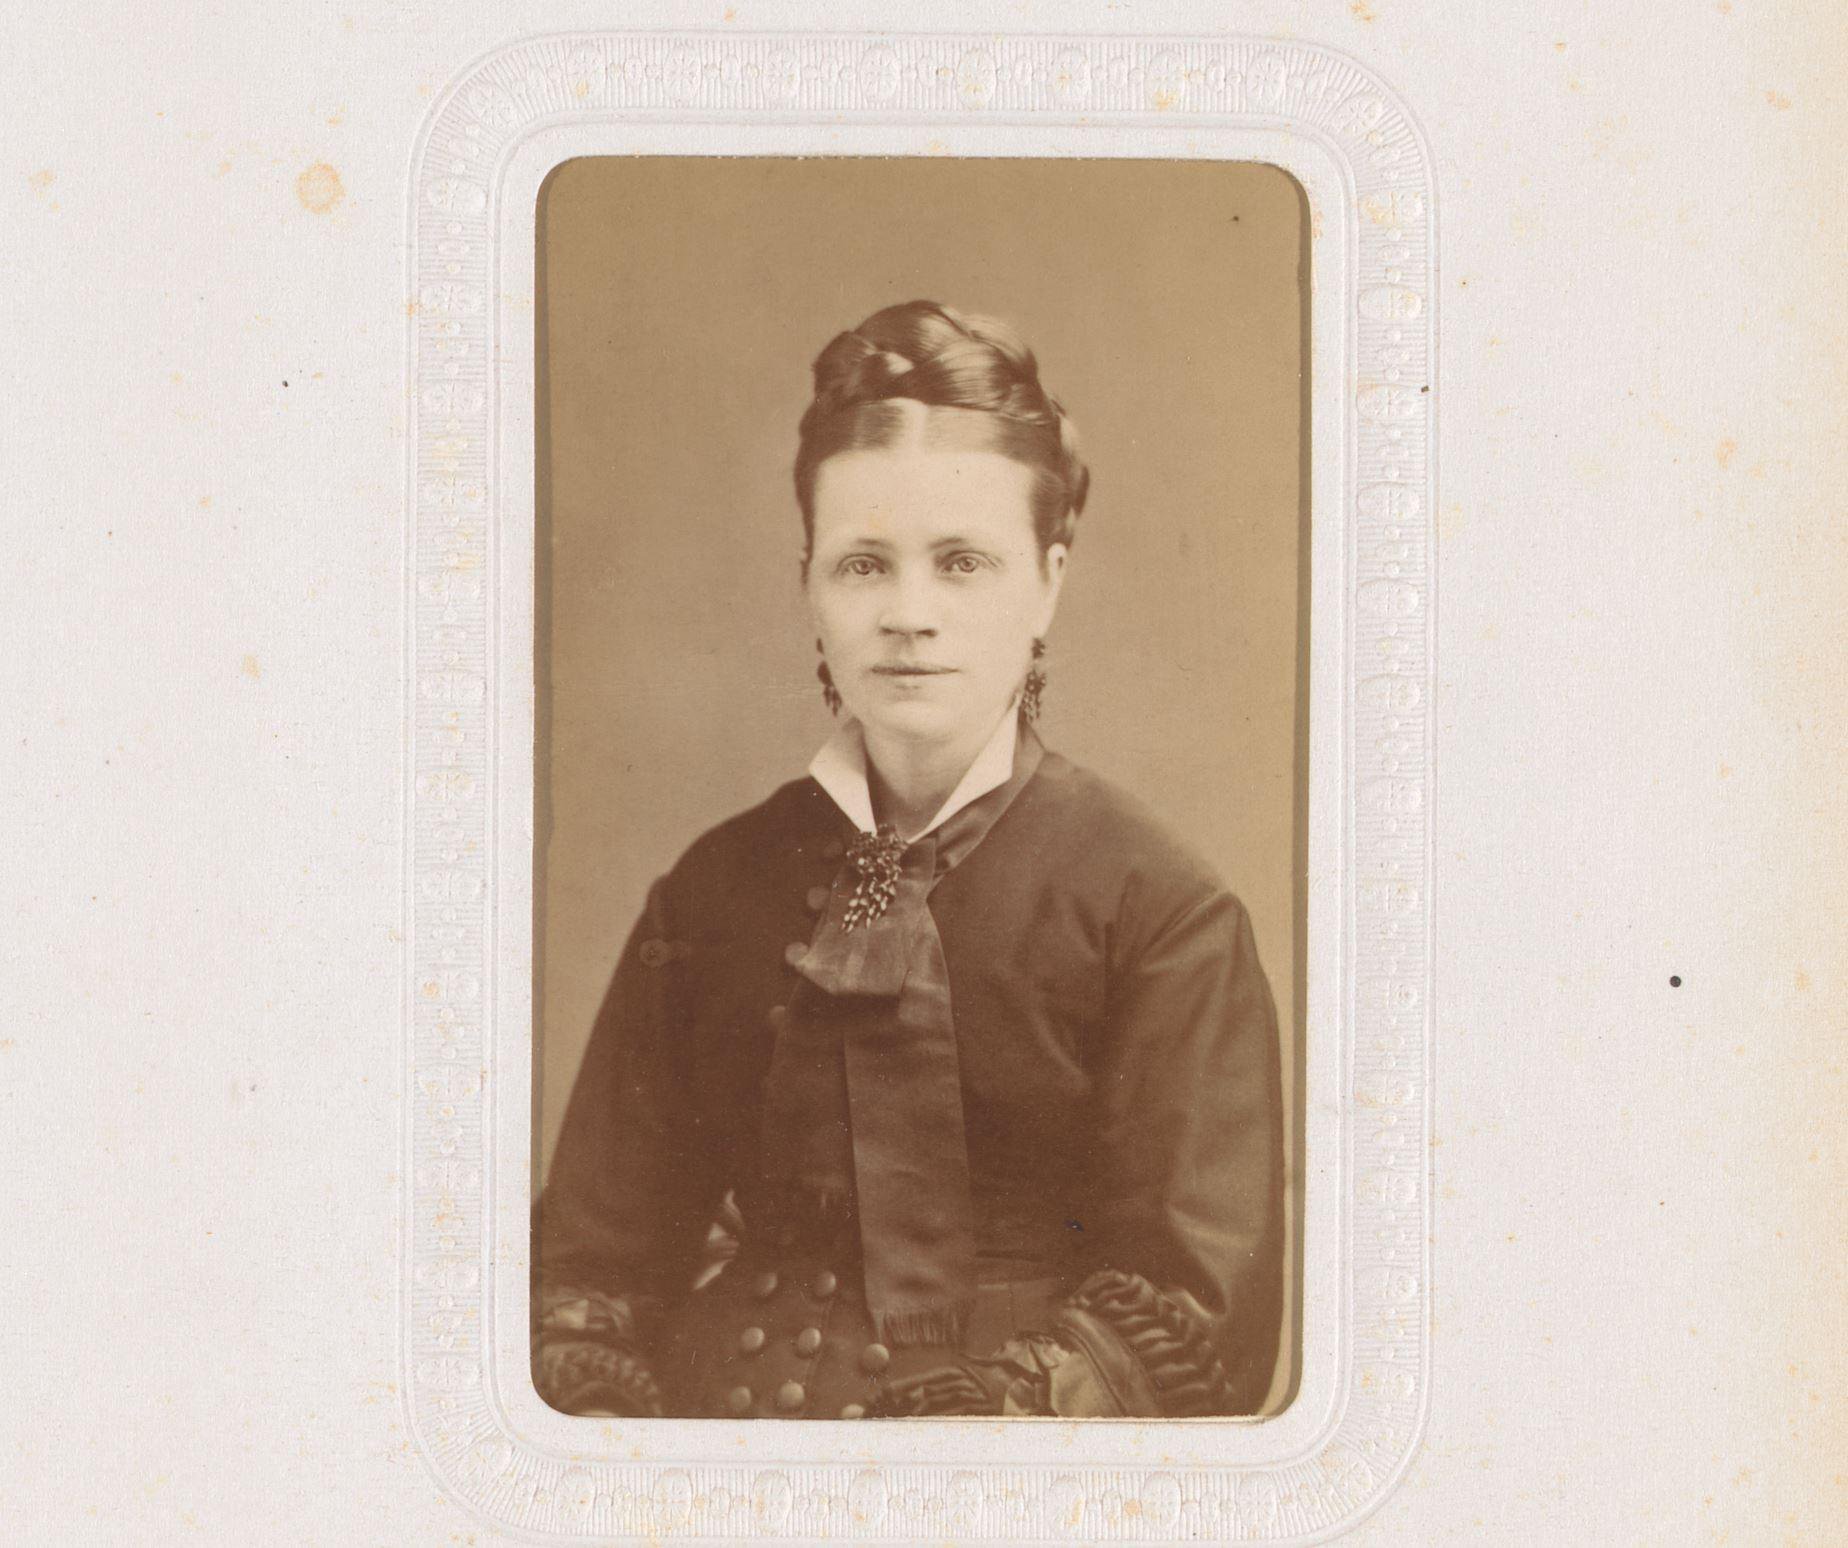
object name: carte de visite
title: Portret van een vrouw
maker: godfried de jong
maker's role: print maker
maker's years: 1832-1918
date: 1850-1880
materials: cardboard, photographic support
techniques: albumen print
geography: groningen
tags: adult woman, historical persons - bb - woman